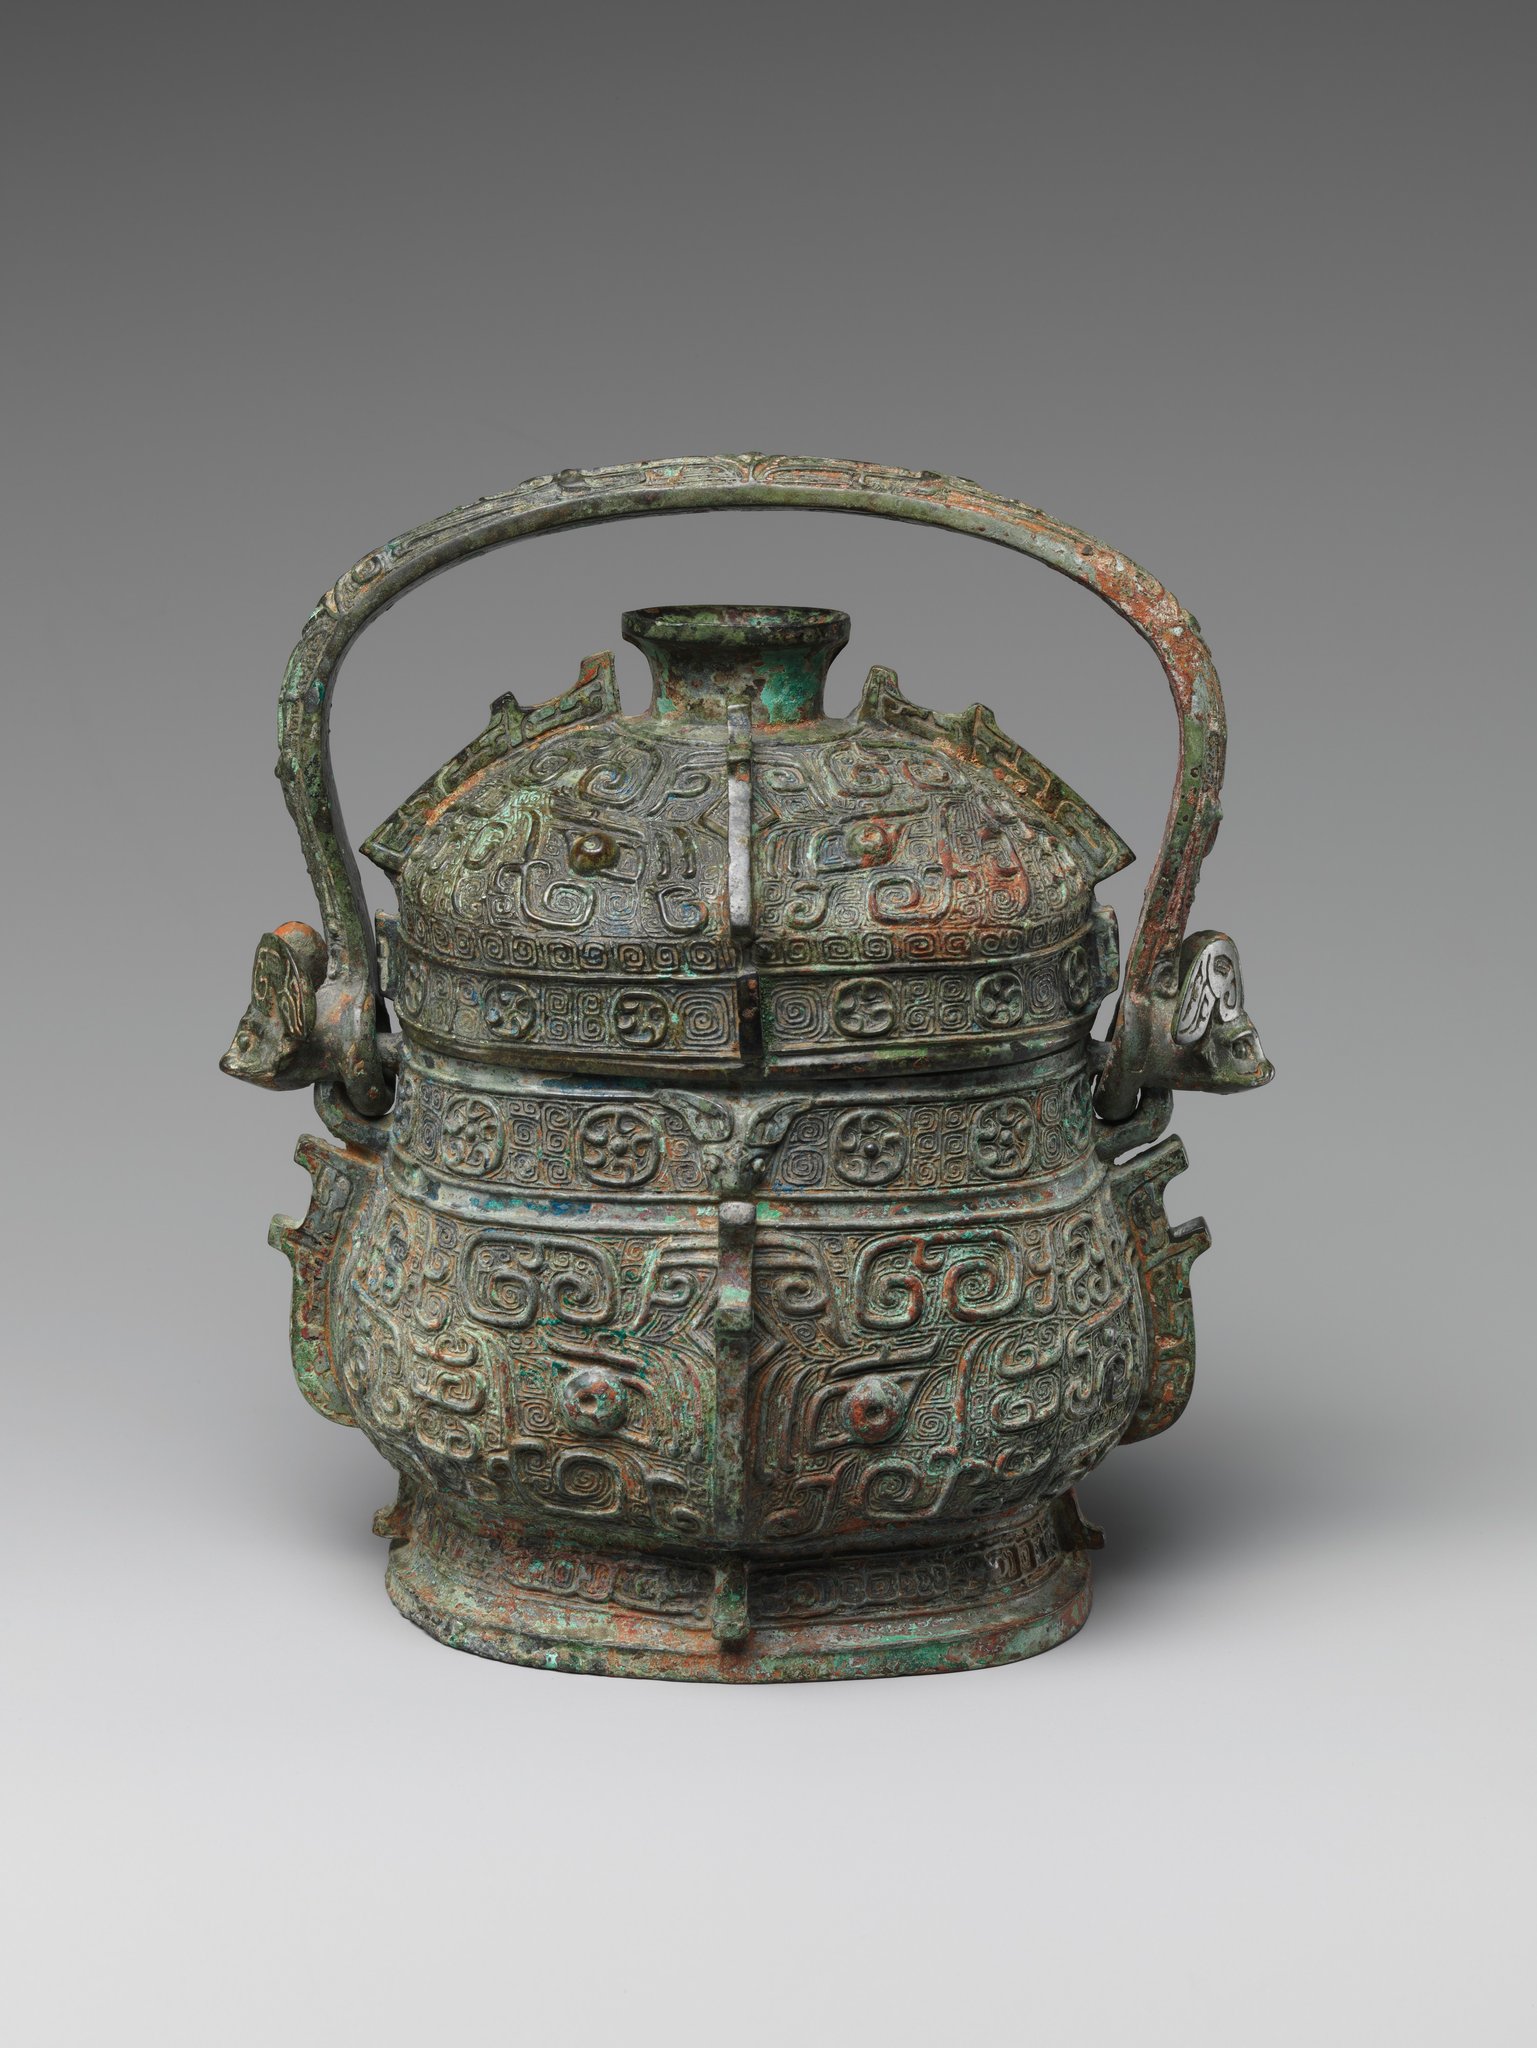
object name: wine container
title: Ritual wine container with handle (You)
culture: chinese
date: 1000-801 BCE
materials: bronze